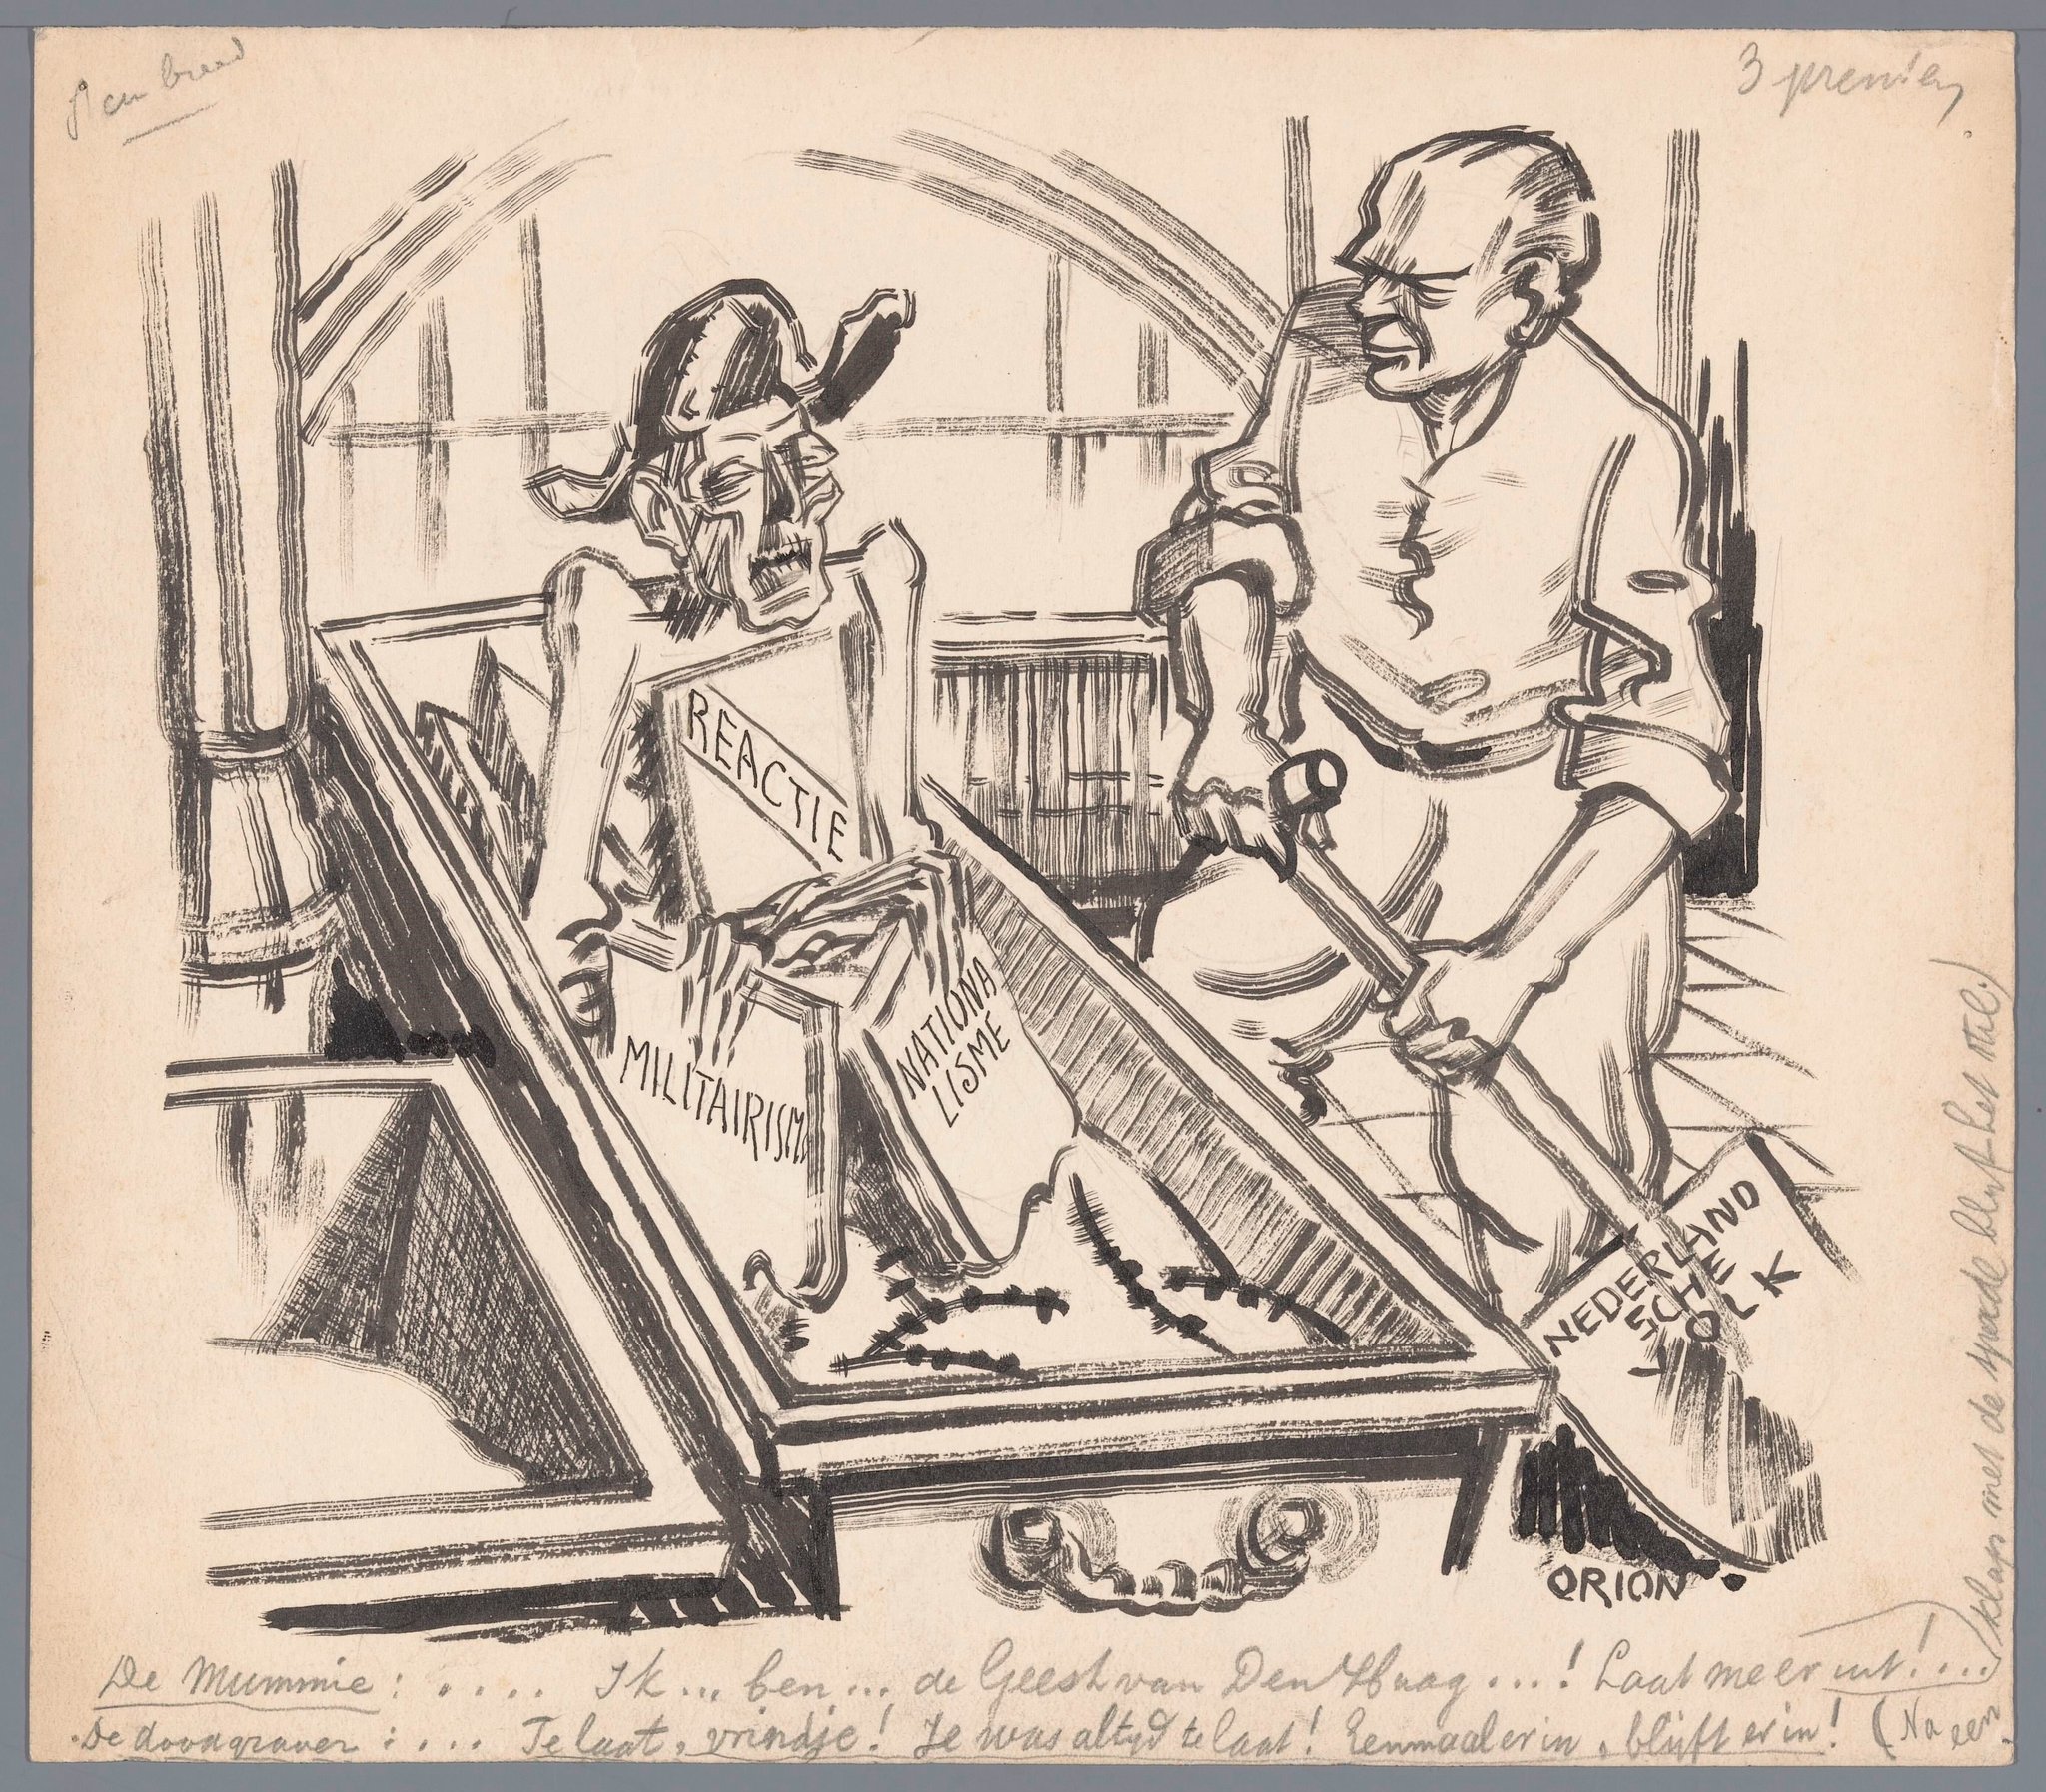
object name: drawing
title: Oplevend nationalisme en militarisme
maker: patricq kroon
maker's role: draughtsman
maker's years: 1862-1941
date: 1920-1935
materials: ink, paper, pencil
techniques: brush, pen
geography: netherlands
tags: militarism, coffin, the corpse, grave digger, political caricatures and satires, mummy, the hague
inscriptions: inscription: ‘De Mummie: Ik ben de Geest van Den Haag! Laat me er uit! ...’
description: De lijk of mummie, de geest van nationalisme en militarisme, staat op uit een doodskist. Een doodgraver met een spade aangeduid als 'Nederlandsche Volk' staat klaar om hem een klap te verkopen. Ontwerp voor een politieke spotprent.